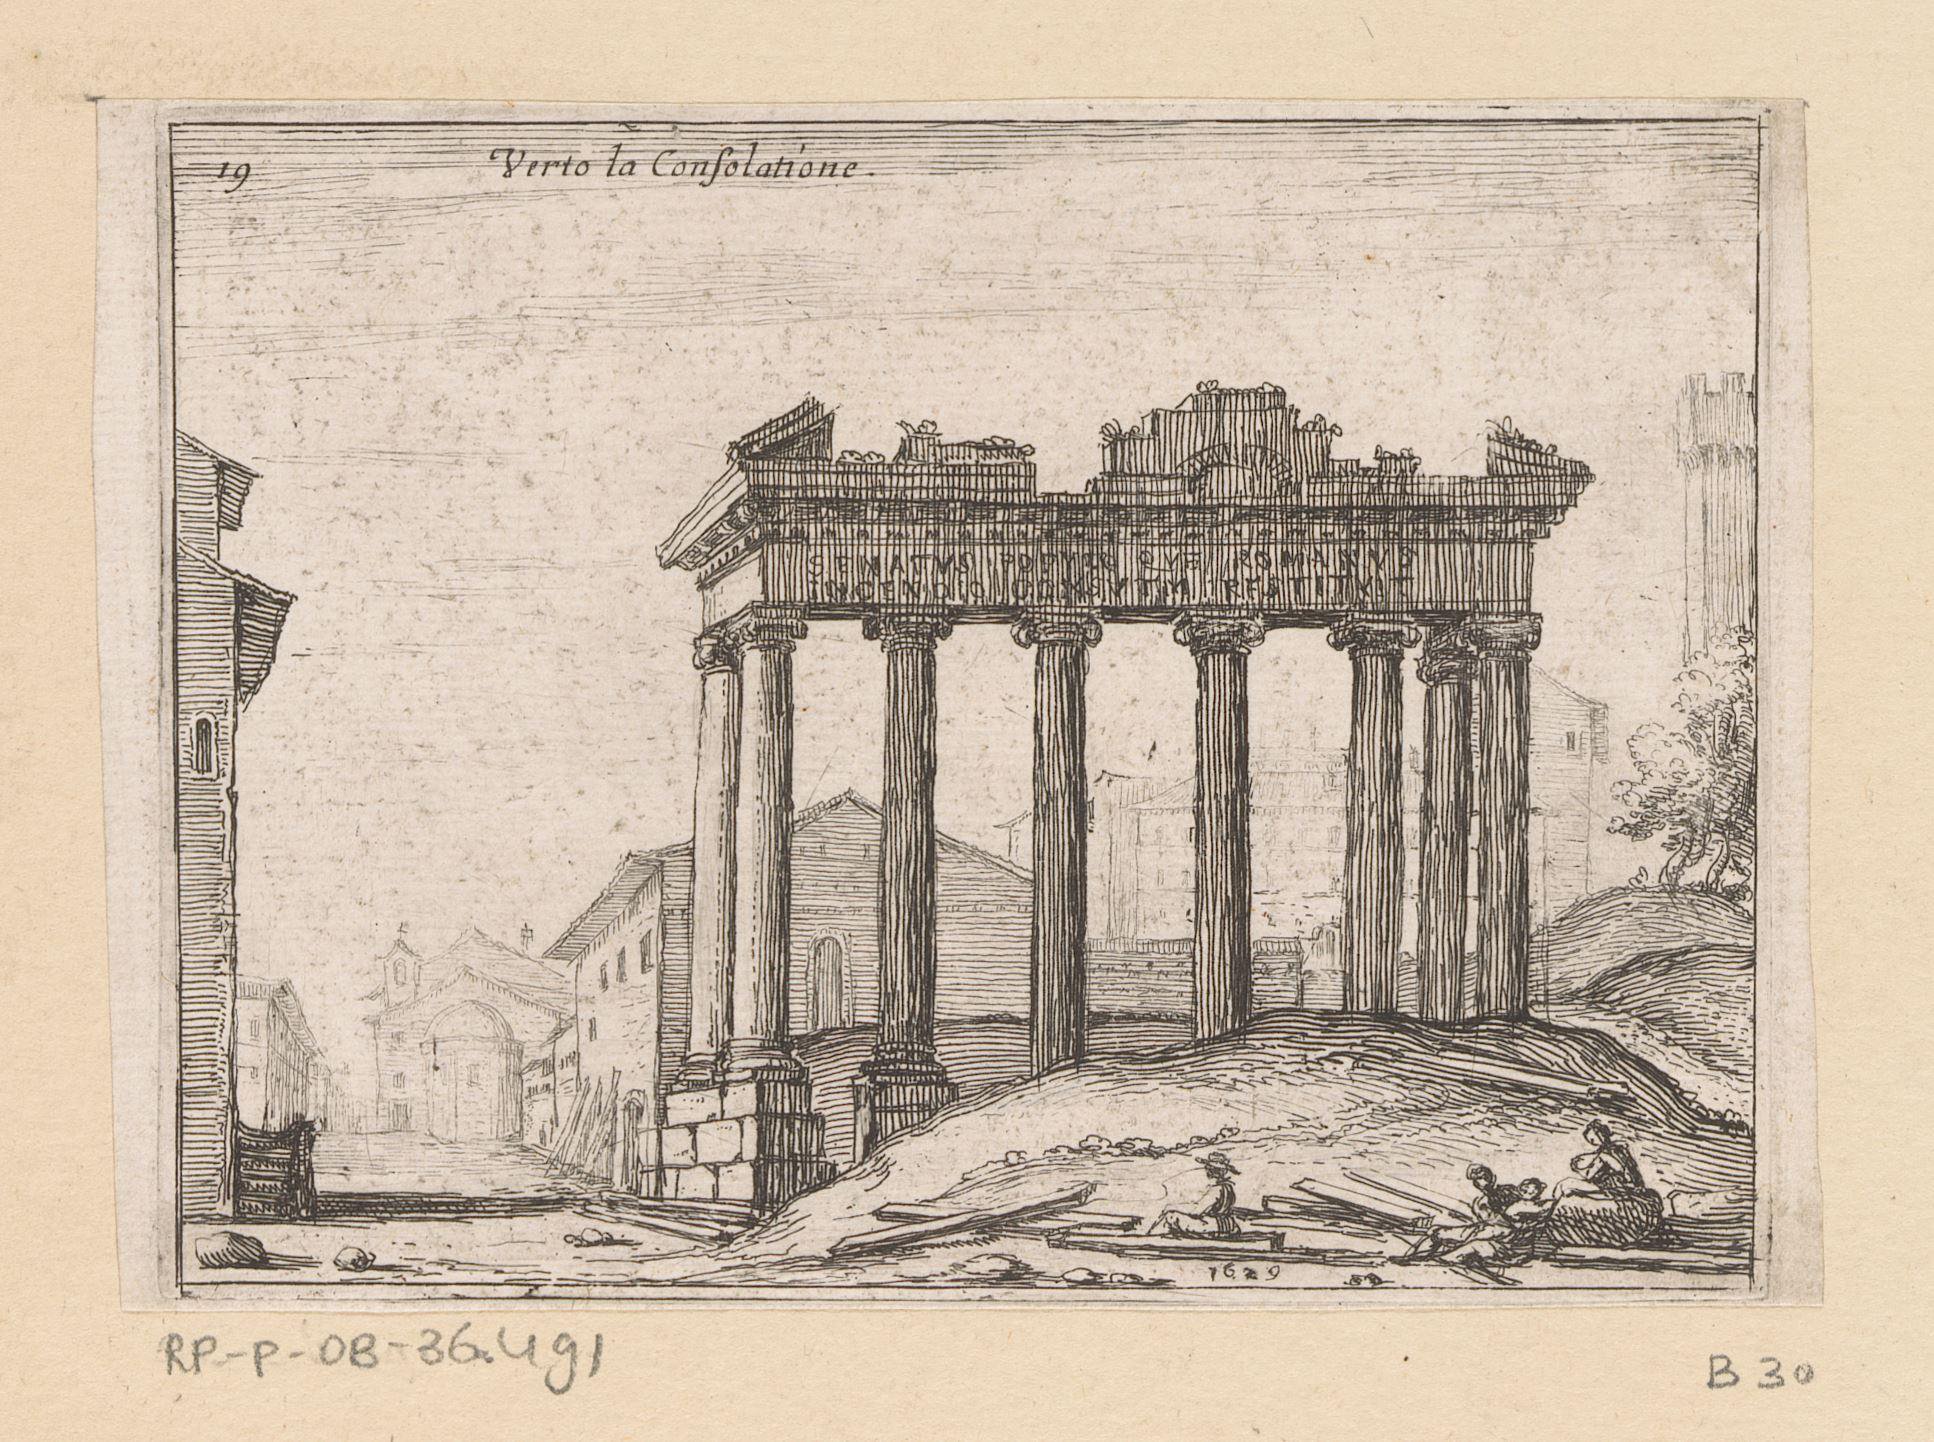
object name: print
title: Alcune vedute et prospettive di luoghi dishabitati di Roma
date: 1629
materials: paper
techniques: etching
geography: tuscany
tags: landscape with ruins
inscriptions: collector's mark: Lugt 2228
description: Deze prent maakt deel uit van een reeks van 52 prenten.